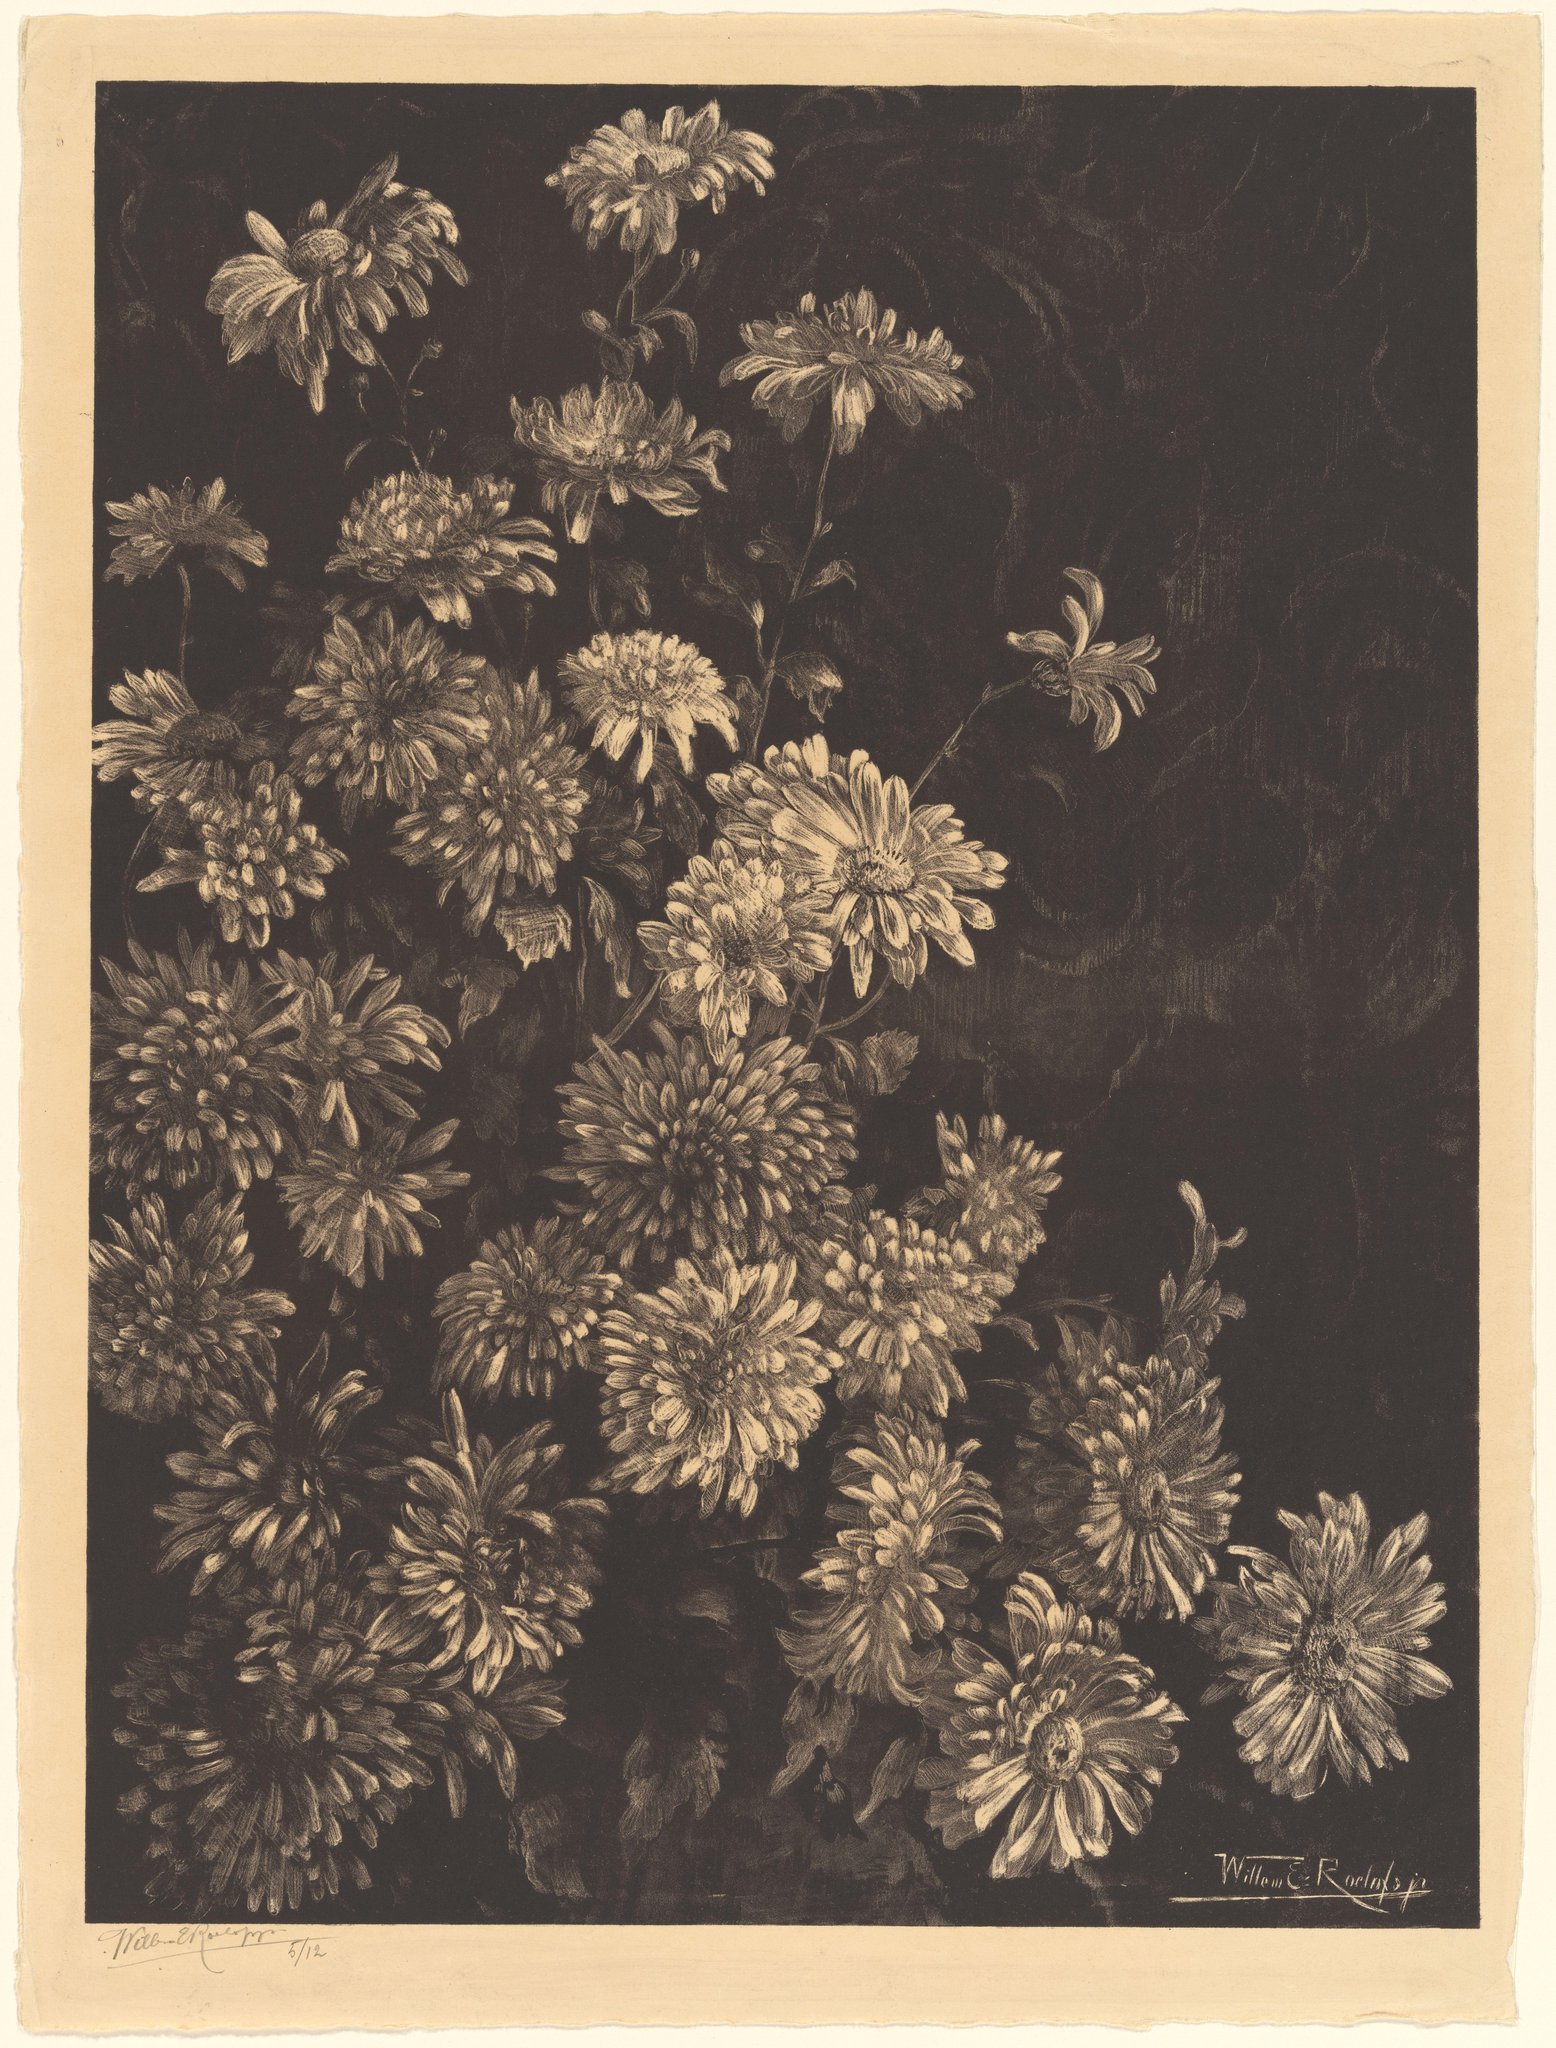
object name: print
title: Chrysanten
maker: willem roelofs (ii)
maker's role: draughtsman, painter, print maker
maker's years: 1874-1940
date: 1884-1931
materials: paper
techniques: lithograph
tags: flowers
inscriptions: collector's mark: Lugt 2228